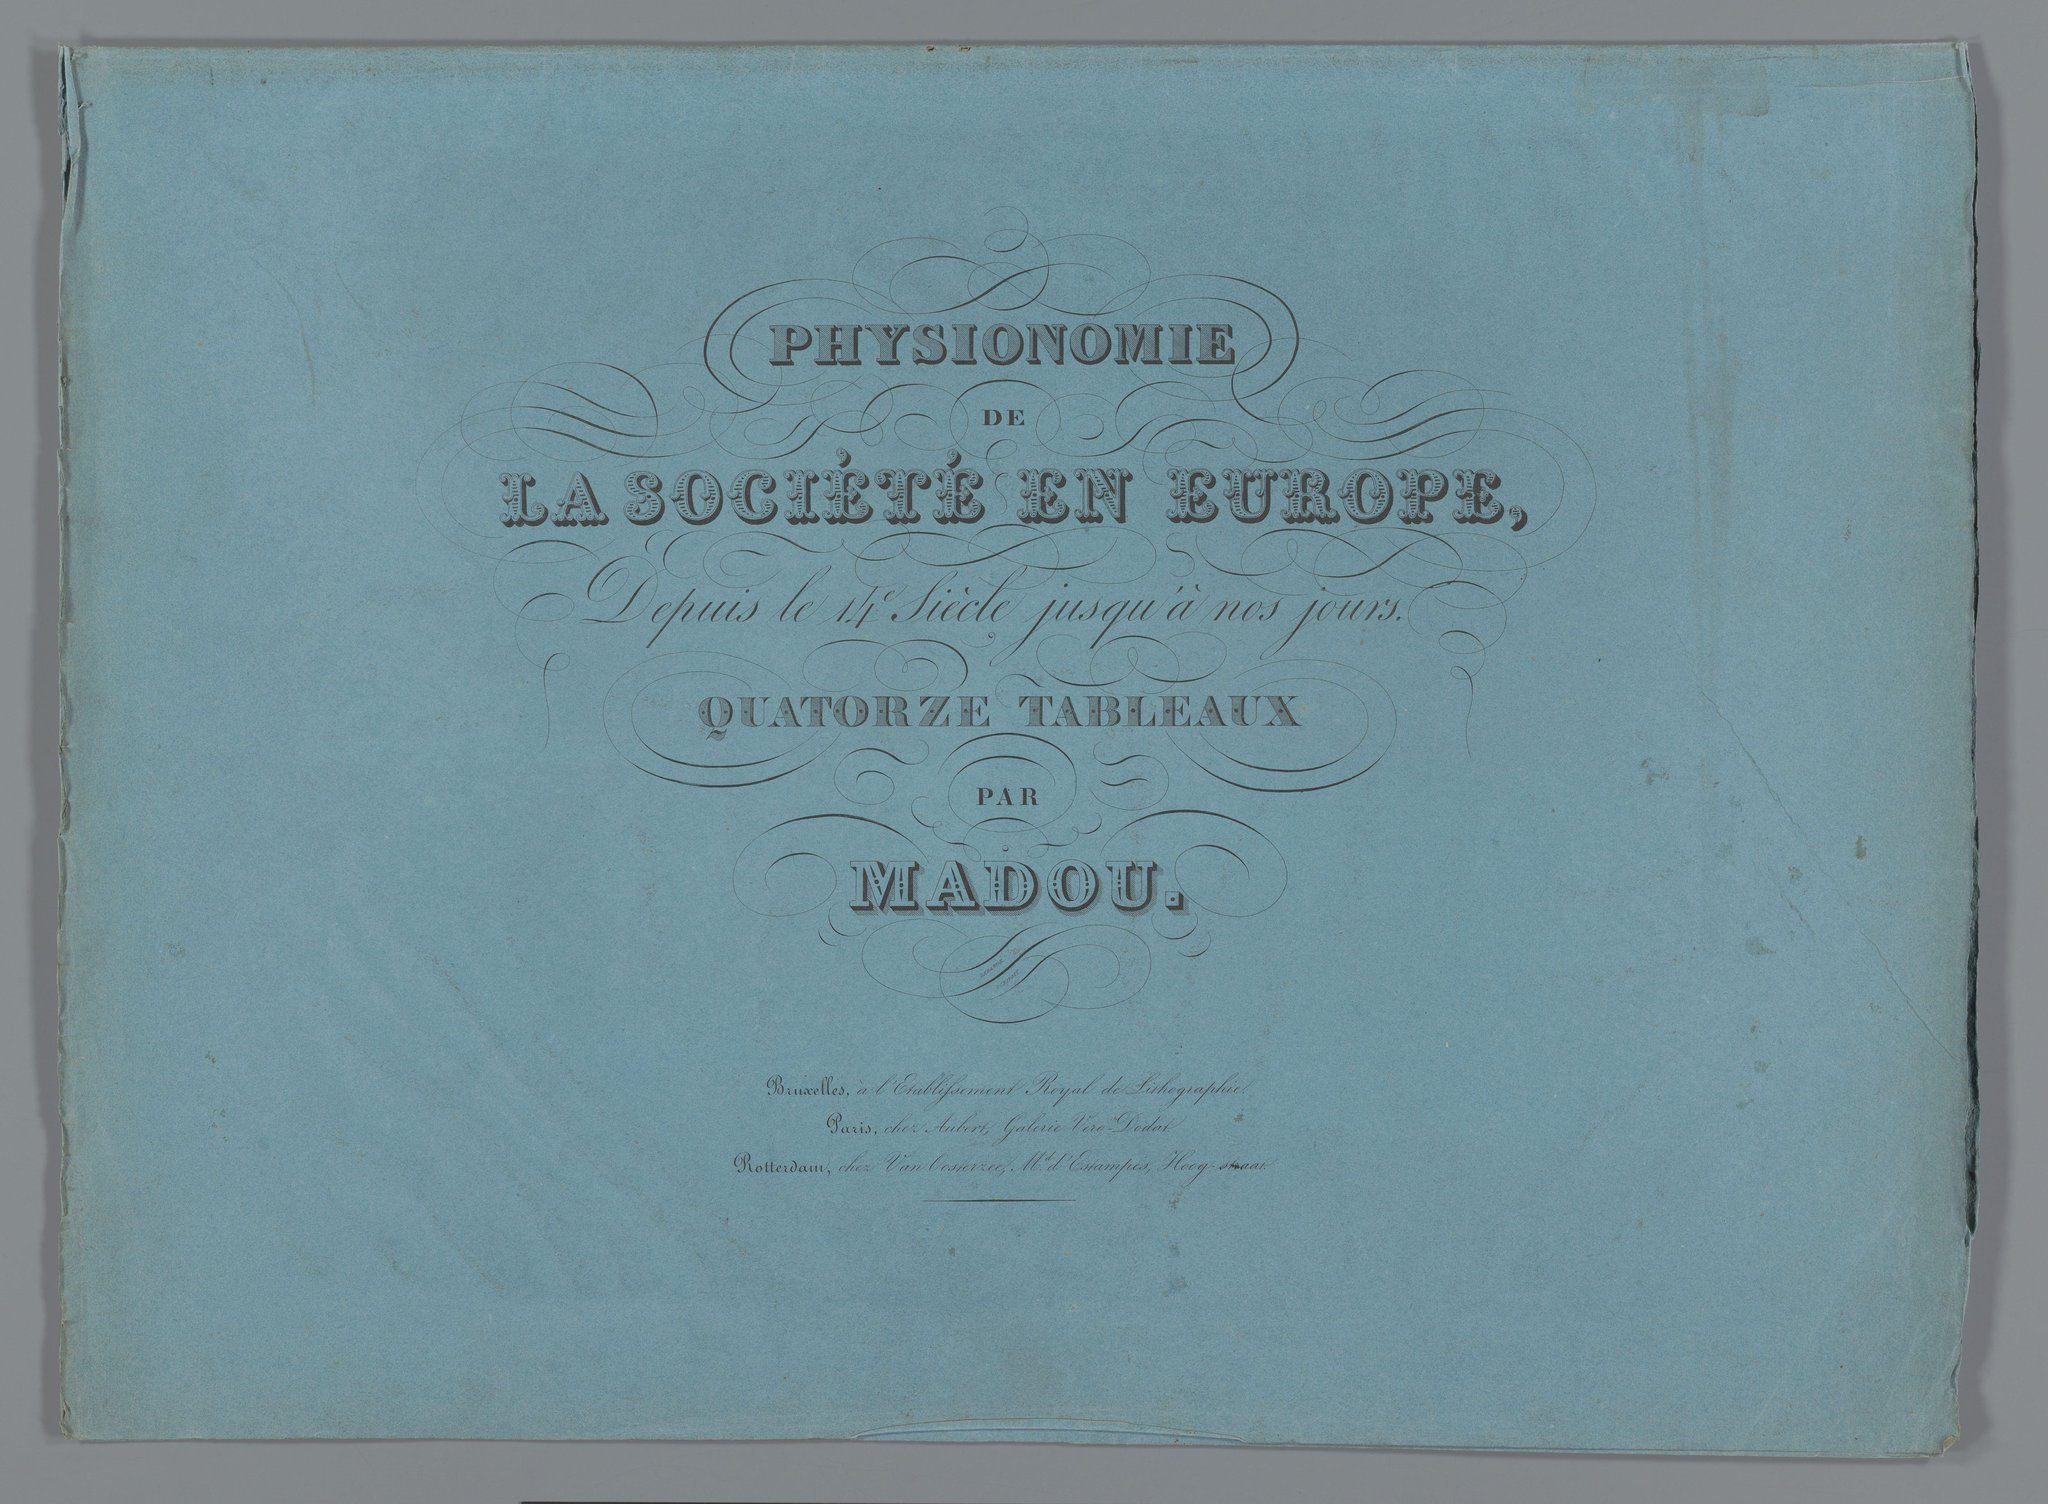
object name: wrapper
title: Fysionomie van de welgestelden in Europa van de vijftiende tot en met de negentiende-eeuw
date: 1835-1837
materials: paper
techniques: lithograph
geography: paris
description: Omslag voor: Physionomie de la société en Europe, depuis 1,400 jusqu' à nos jours. Quatorze tableaux, par Madou. Brussel: Dewasme-Pletinckx, [1835-1837].